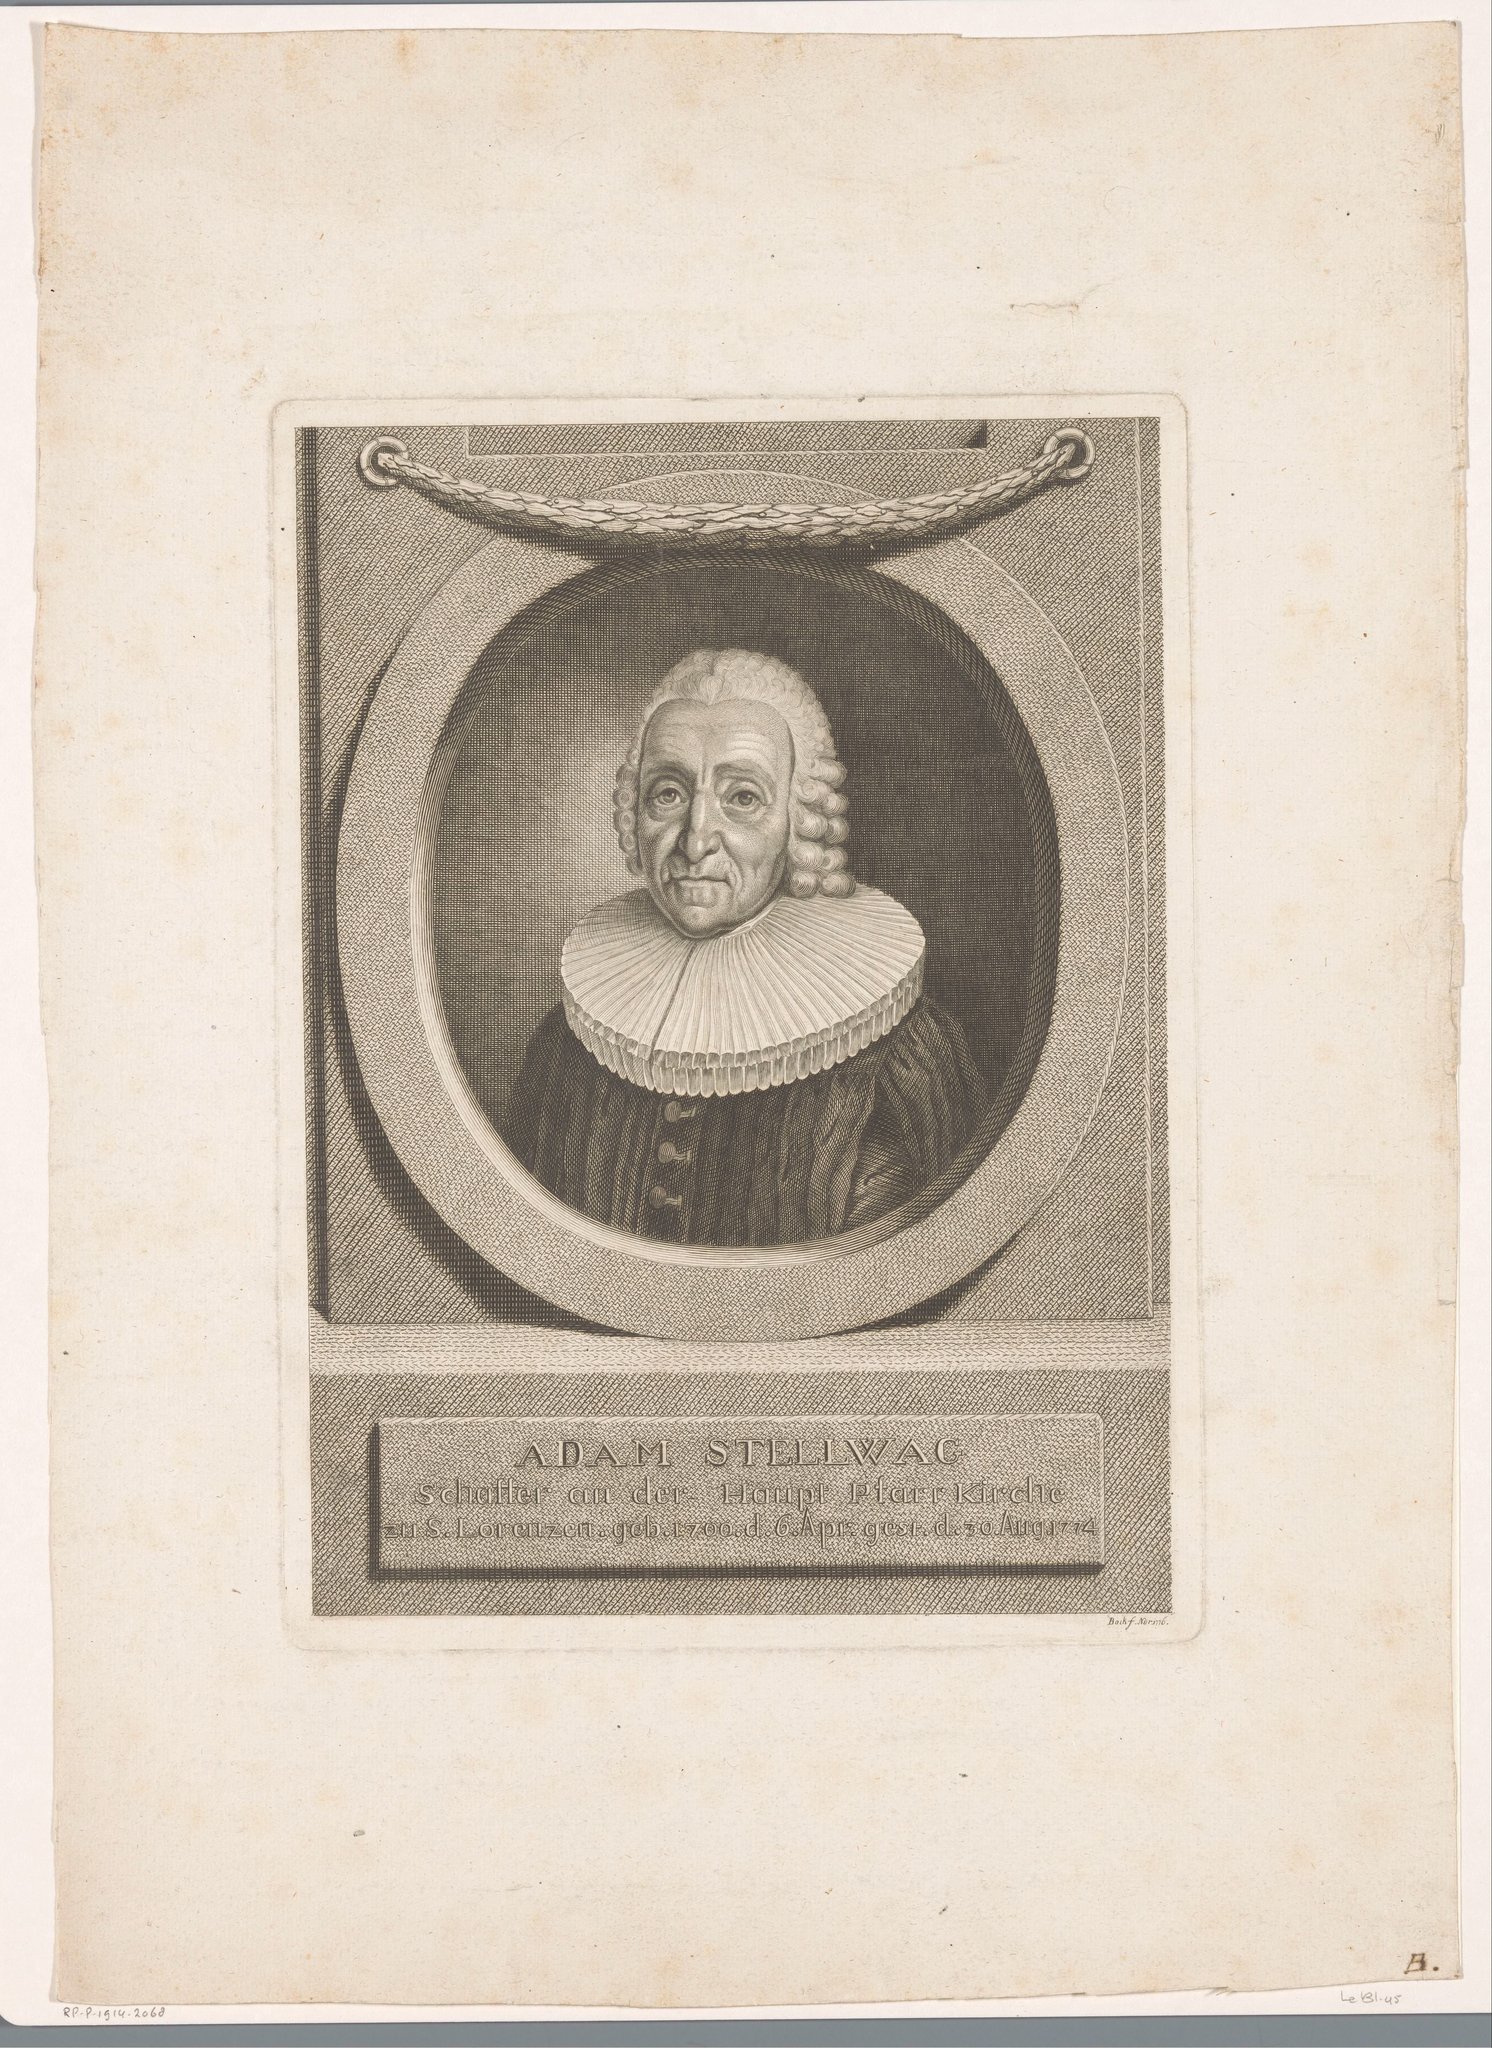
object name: print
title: Portret van Adam Stellwaag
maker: christoph wilhelm bock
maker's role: print maker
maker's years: 1755-1836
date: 1776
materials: paper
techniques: engraving, etching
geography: nuremberg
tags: historical persons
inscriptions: collector's mark: Lugt 2228